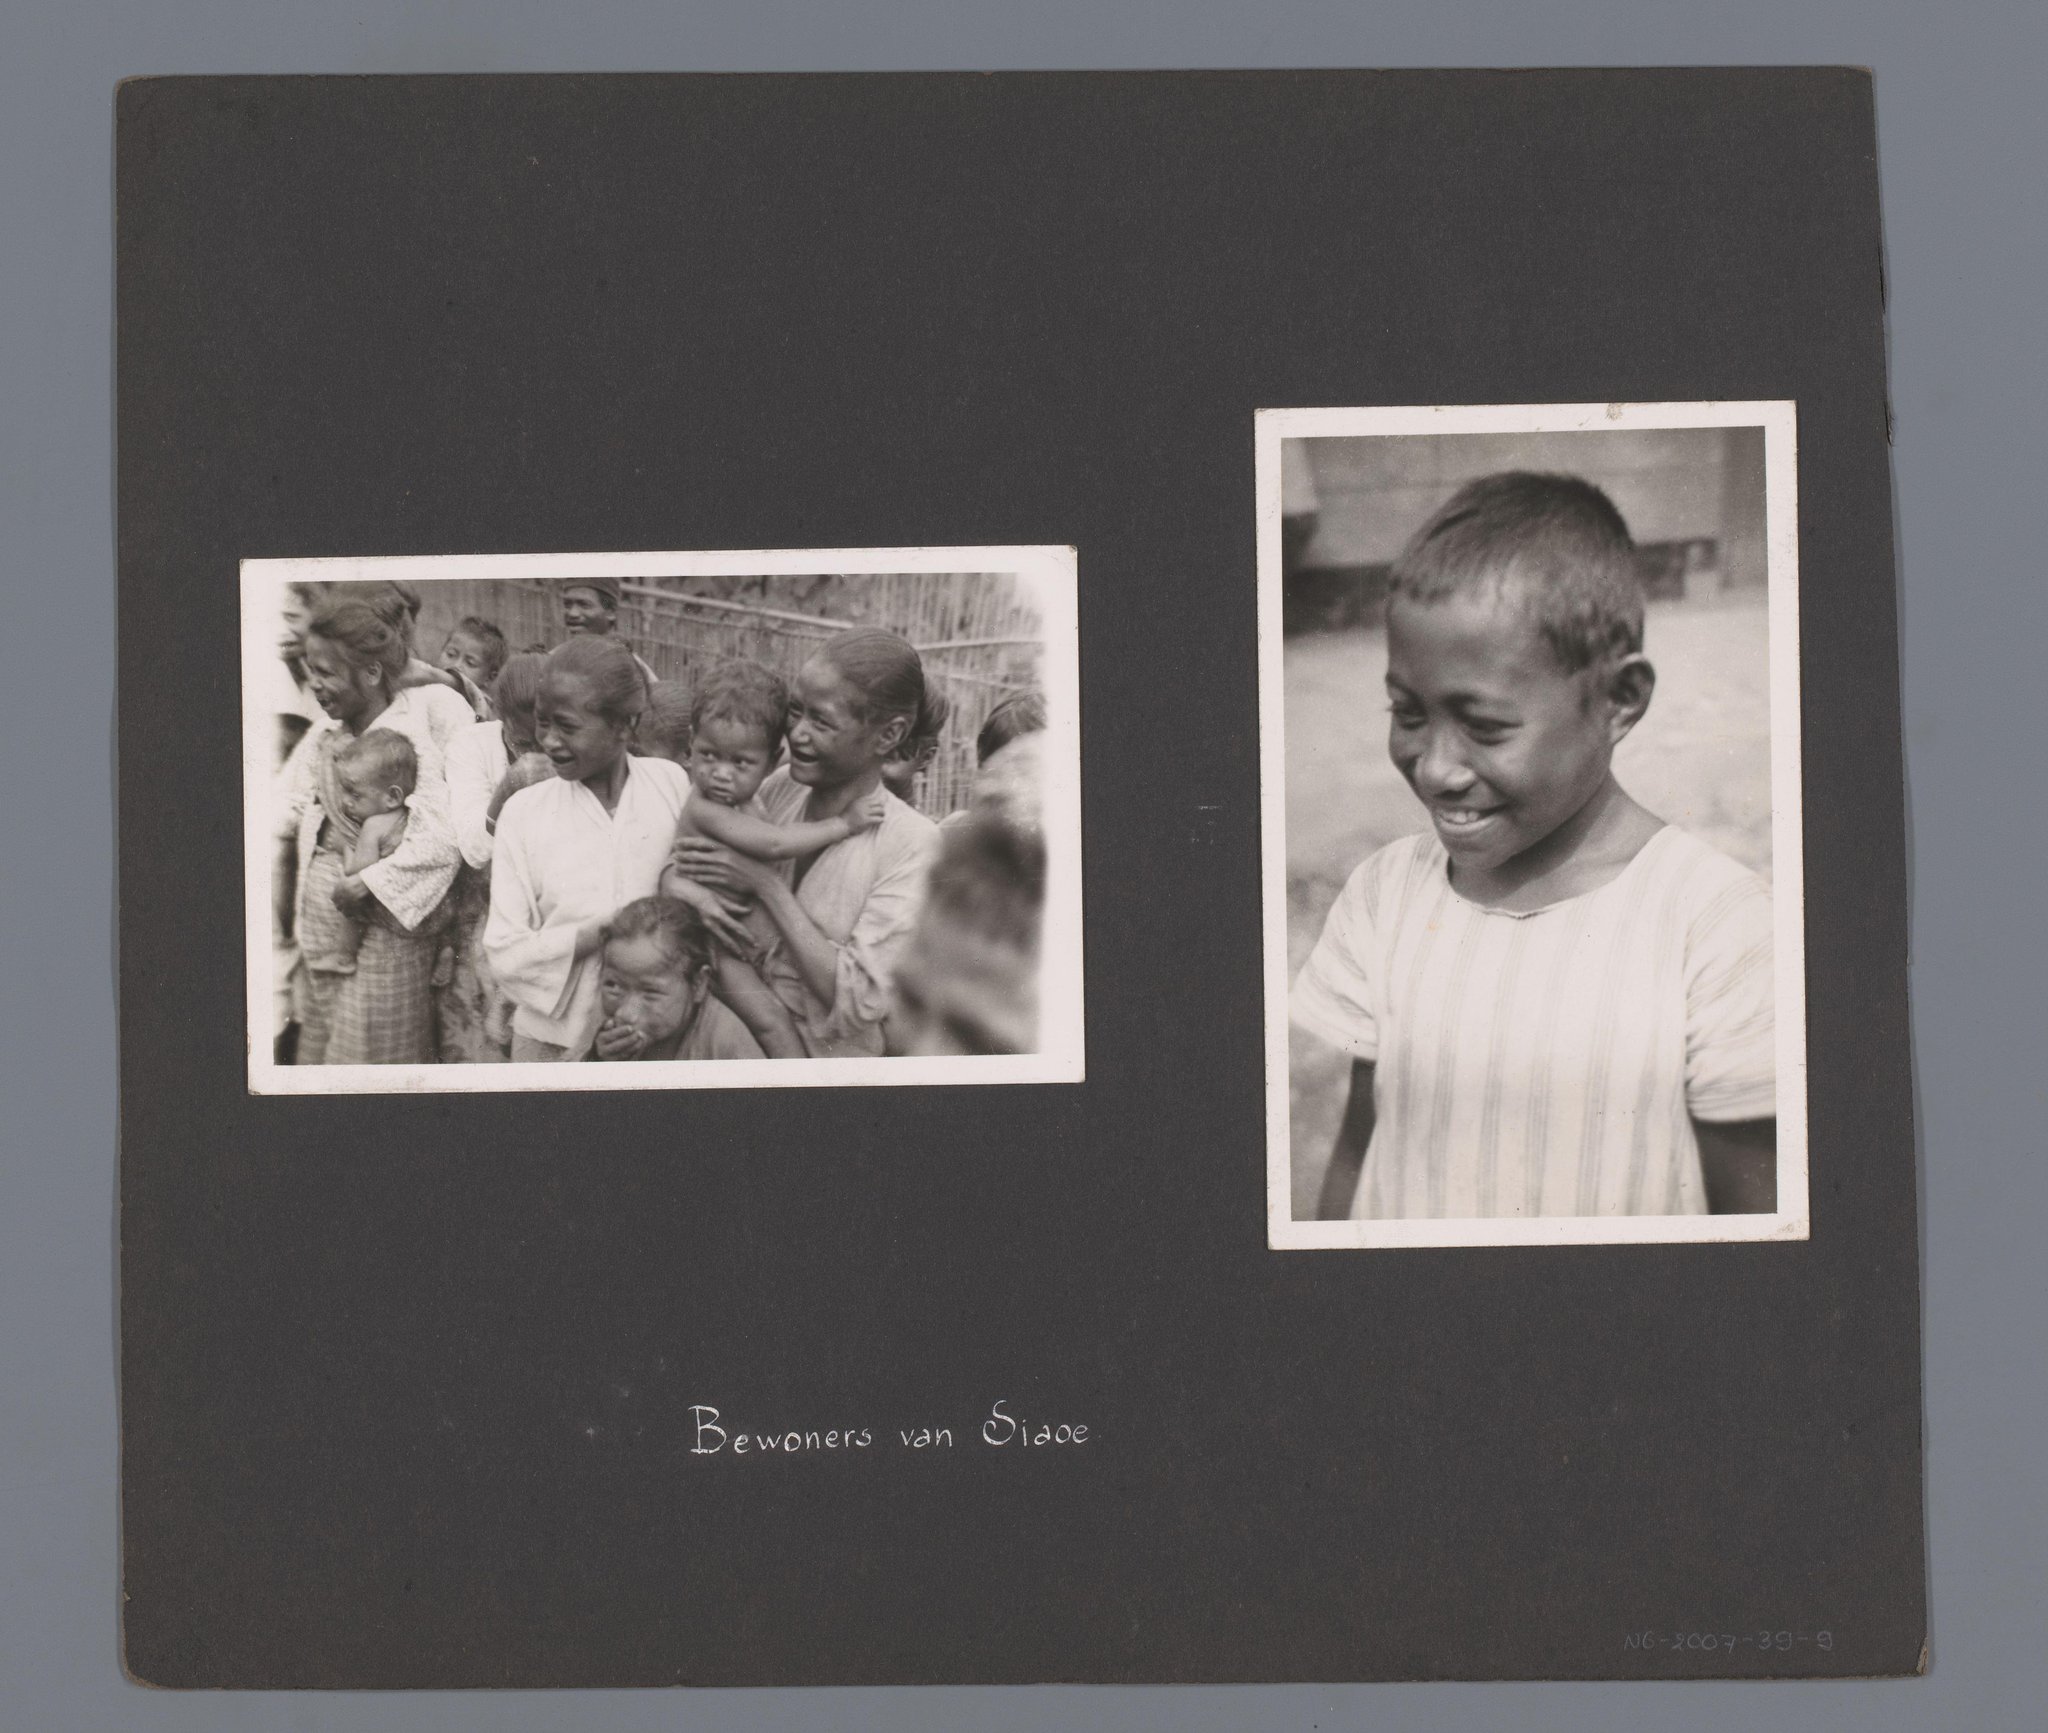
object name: photograph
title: Bewoners van Siaoe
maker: Anonymous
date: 1930-1939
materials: paper, photographic support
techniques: gelatin silver print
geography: celebes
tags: asiatic races and peoples (indonesians)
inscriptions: annotation: ‘Bewoners van Siaoe’, annotation: ‘Huizen langs de kust // Bamboebrug // 't Strand van Kema’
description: Zwart albumblad met twee foto's van een groep Indische vrouwen met jonge kinderen en van een jongen. Volgens het opschrift inwoners van het eiland Siau. Op de ongenummerde achterzijde van het albumblad bevinden zich drie opschriften zonder foto's. Onderdeel van het losbladig fotoalbum over de Fraters van Tilburg op Celebes en Sumatra.